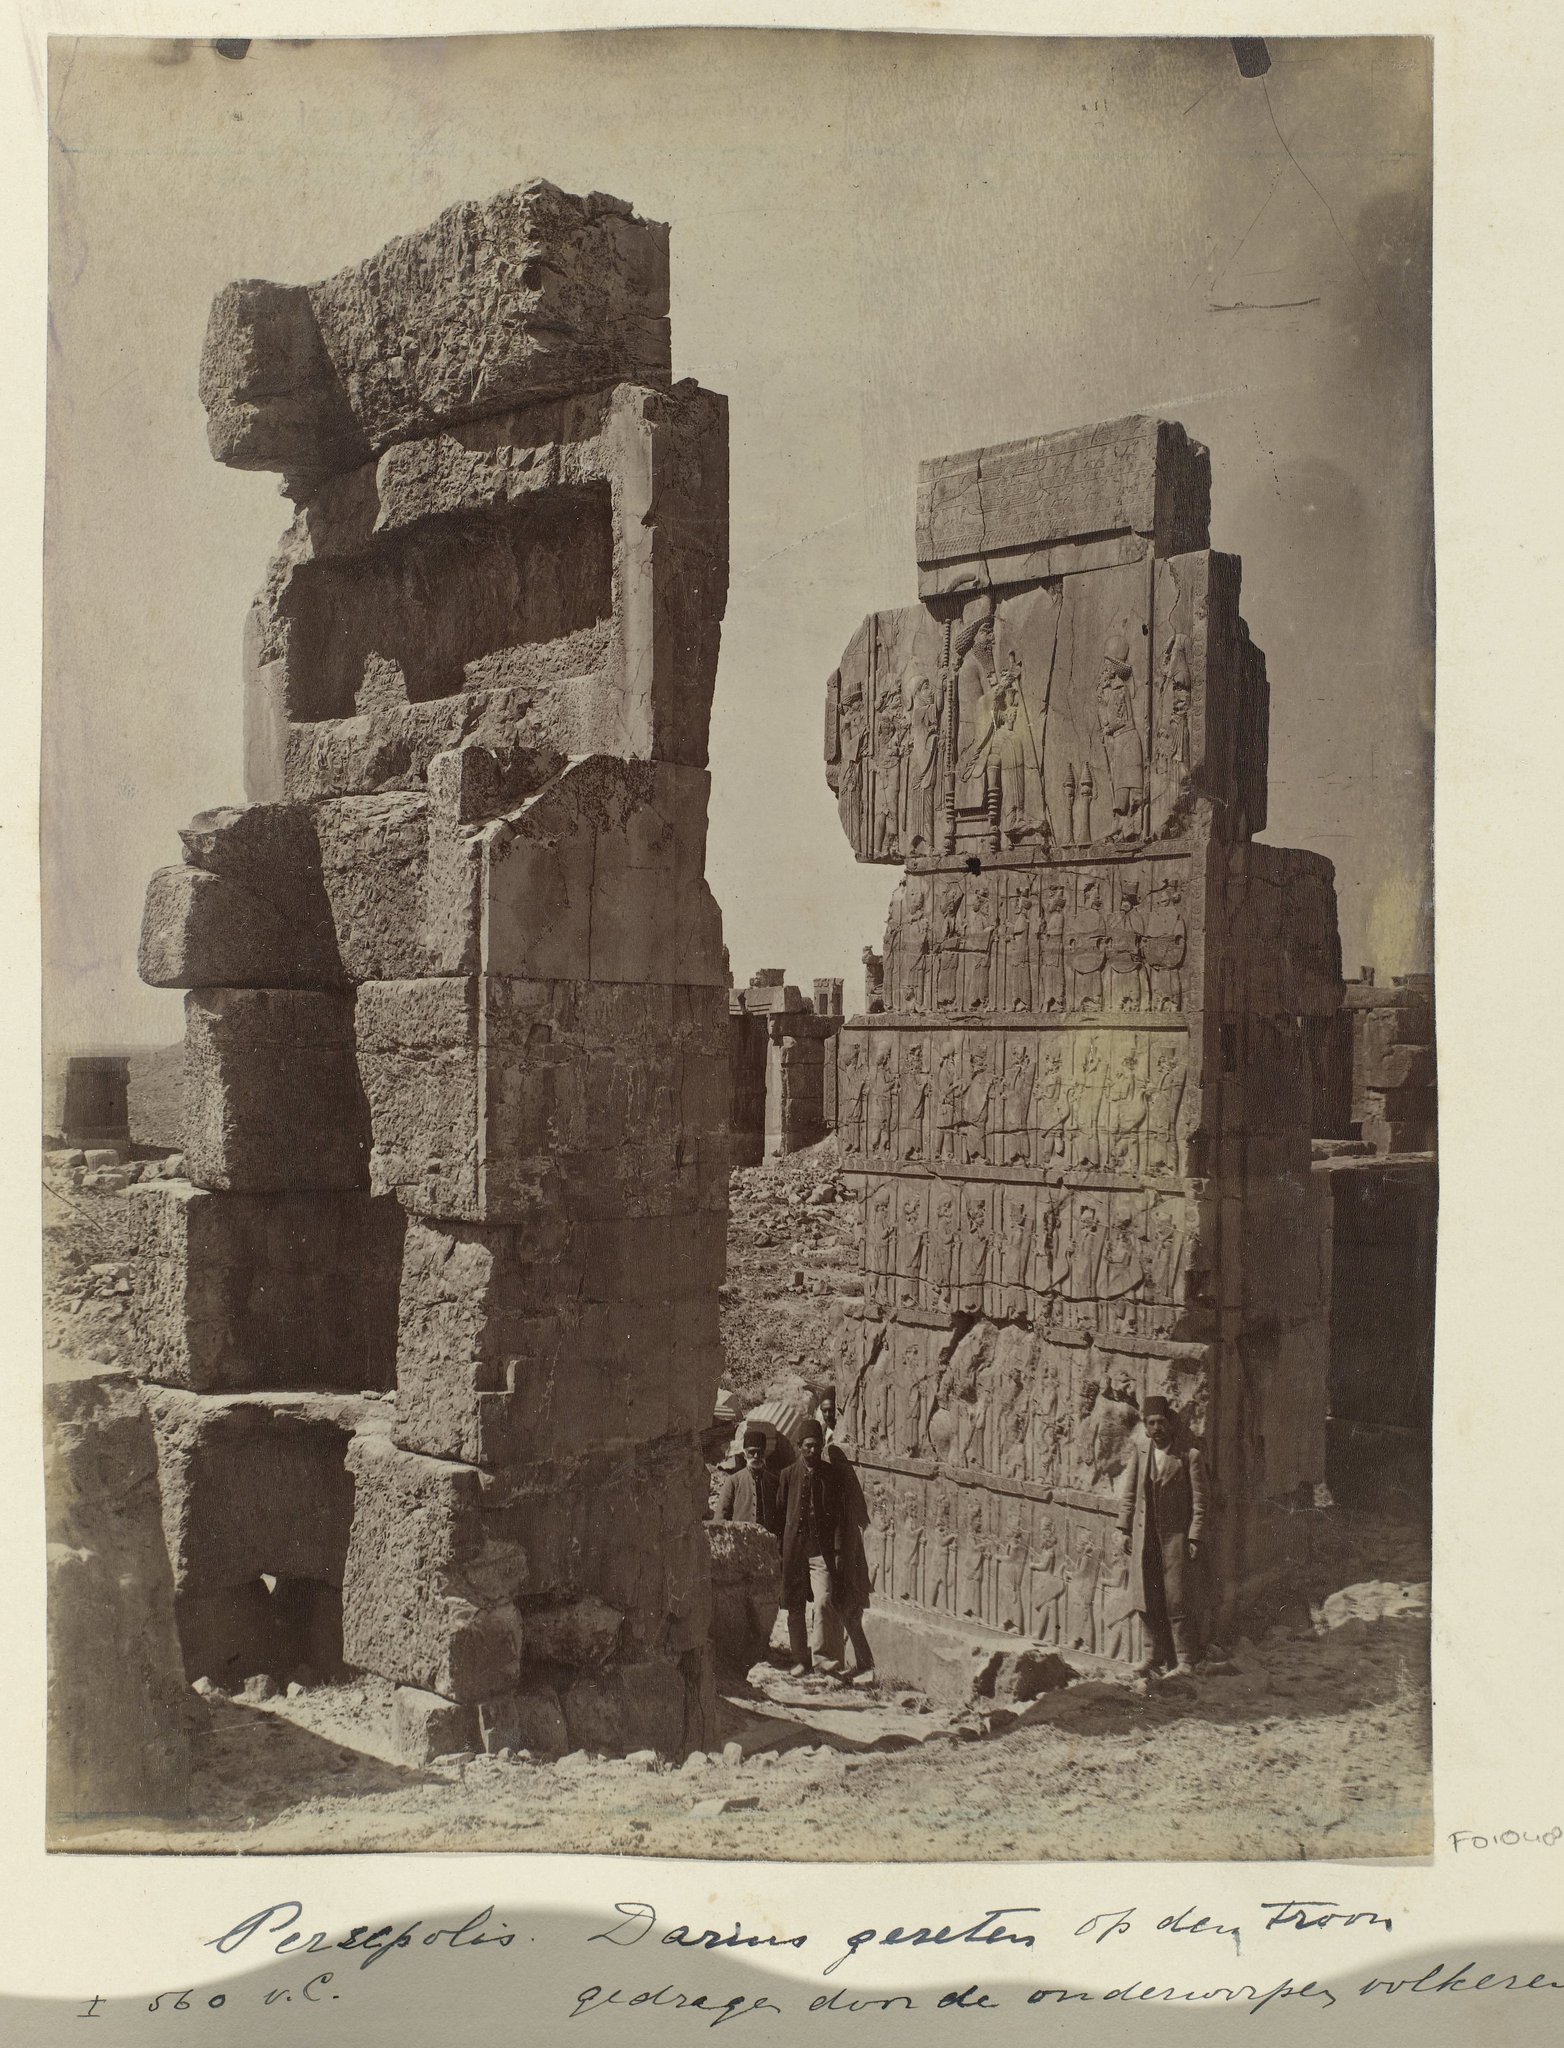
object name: photograph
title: Drie mannen poserend bij een reliëf bij een ingang van de Zaal van Honderd Zuilen in Persepolis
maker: antoine sevruguin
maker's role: fotograaf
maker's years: 1840-1933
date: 1880-1895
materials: paper, photographic support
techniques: albumen print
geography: takht-e jamshid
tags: gate, entrance, sculpture (+ relief ~ sculpture)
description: Onderdeel van Reisalbum van H. Dunlop met foto's van bezienswaardigheden in Perzië, Schotland, Duitsland, Rusland, China en Canada.